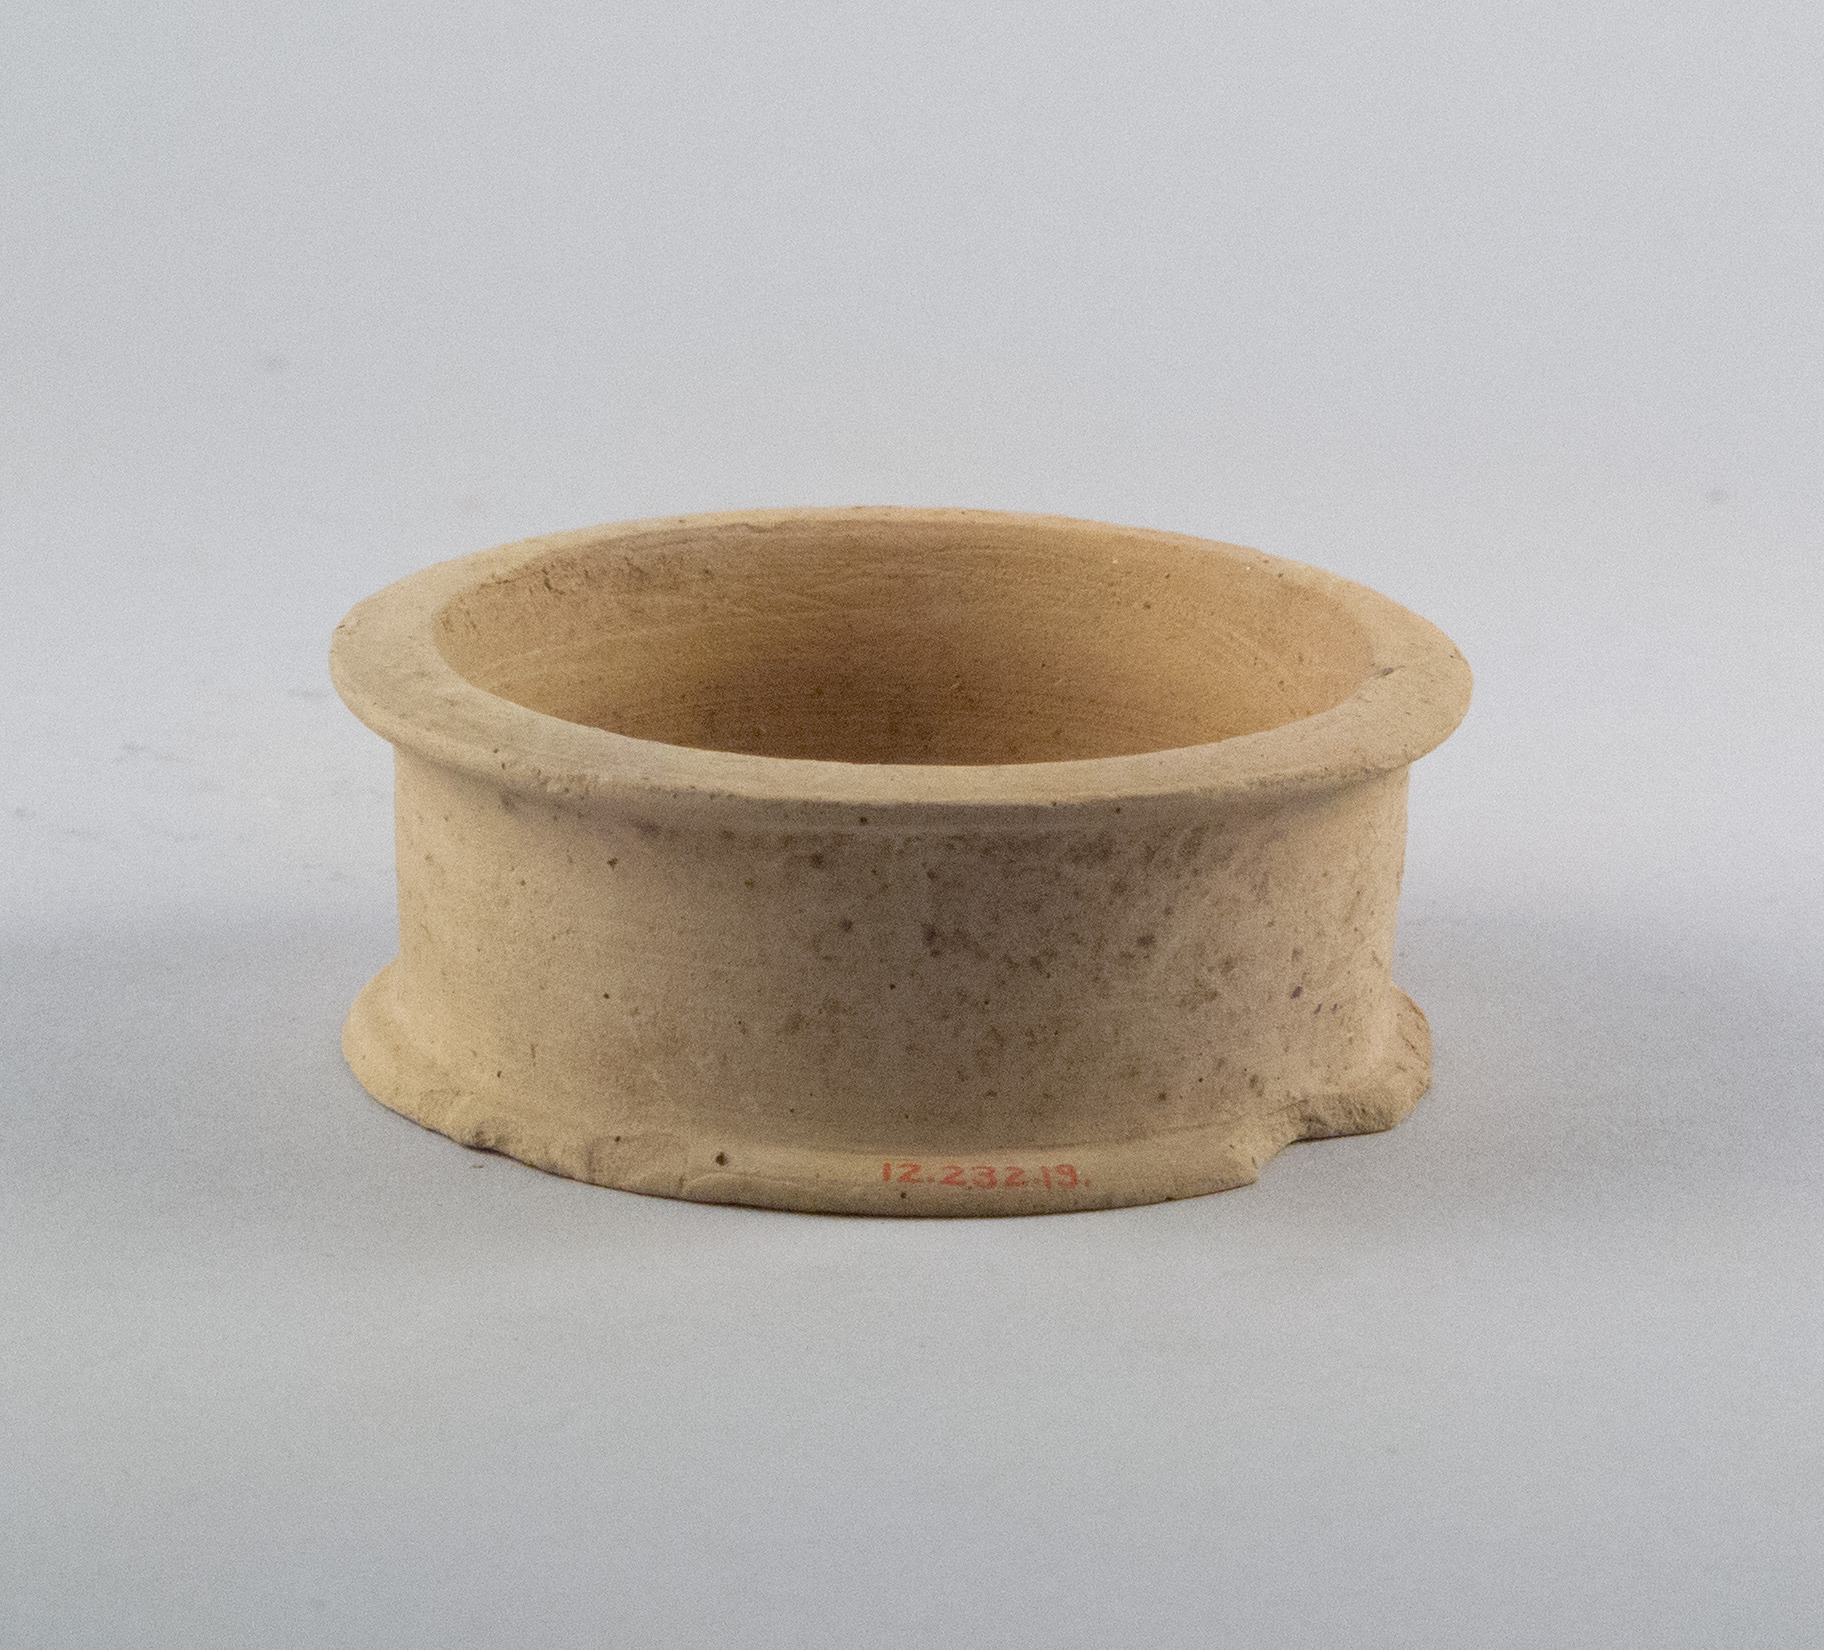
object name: statue base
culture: greek or south italian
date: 7000-30 BCE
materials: terracotta